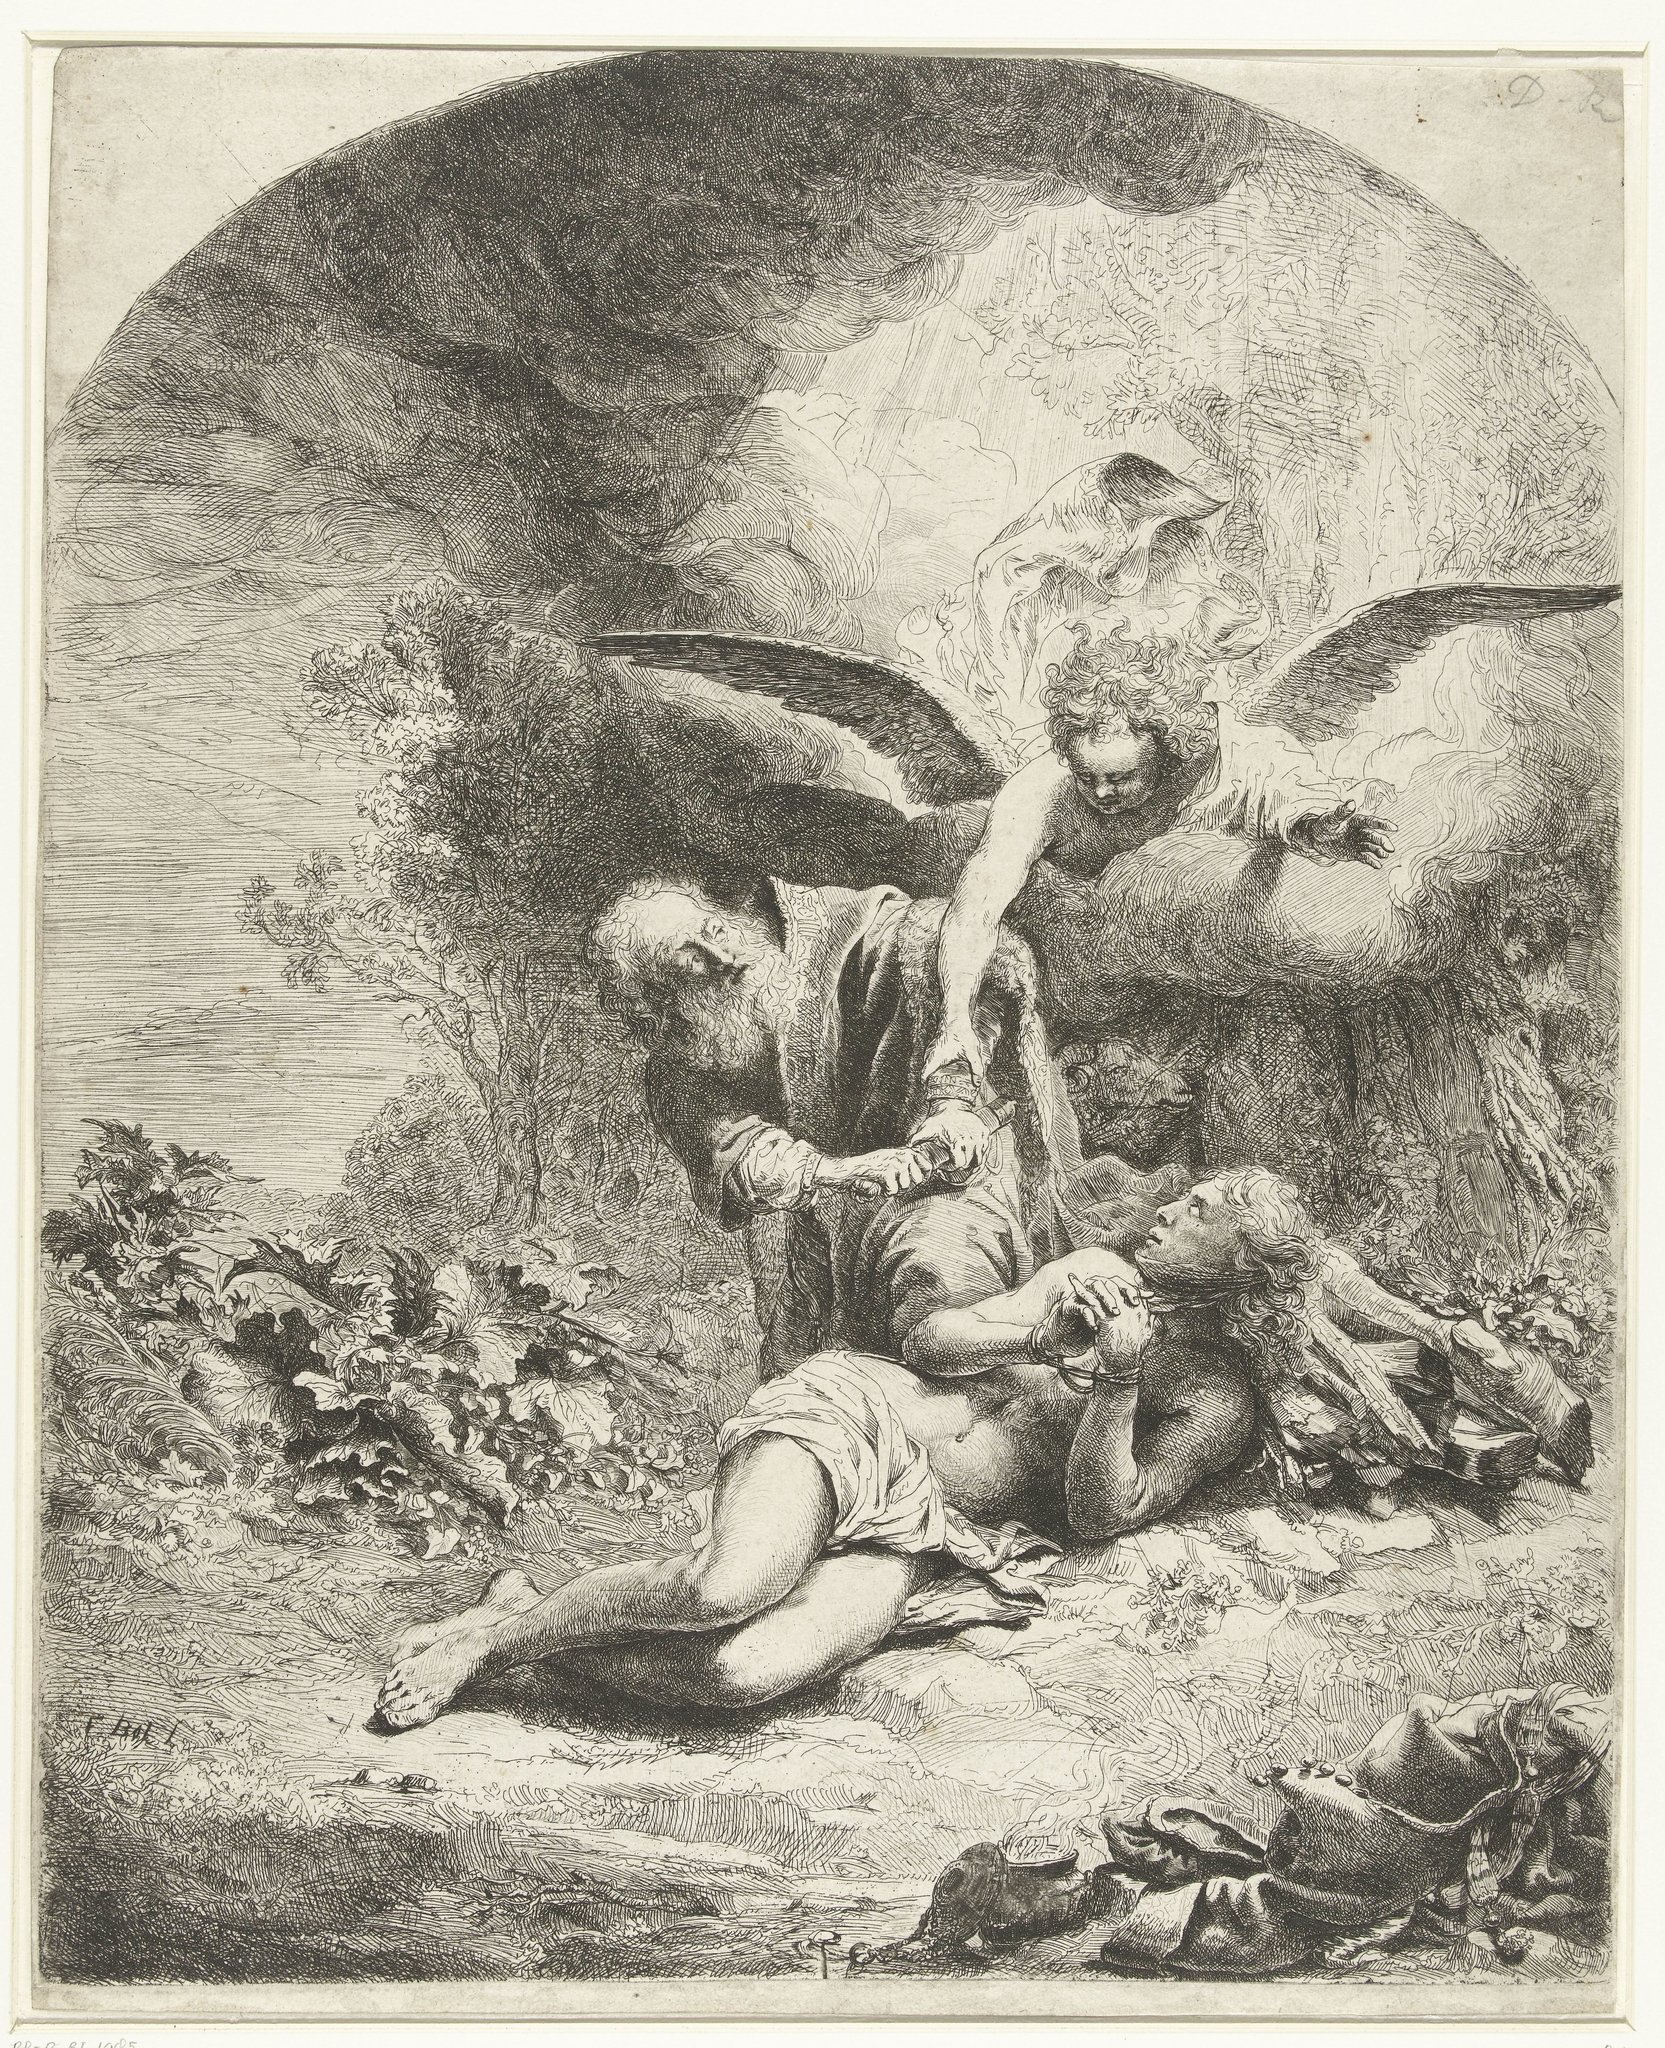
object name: print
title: Offer van Abraham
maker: ferdinand bol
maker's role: draughtsman, painter, print maker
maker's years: 1616-1680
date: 1632-1680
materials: paper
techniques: drypoint, etching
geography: netherlands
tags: when abraham has his hand raised to kill isaac, an angel restrains abraham's hand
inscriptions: collector's mark: Lugt 240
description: Isaak ligt half naakt en geboeid op de grond, bij zijn hoofd ligt een stapel brandhout. Zijn vader Abraham zit naast hem en staat op het punt het mes uit de schede te trekken, uit de hemel komt een engel die zijn arm vastpakt en hem tegenhoudt.